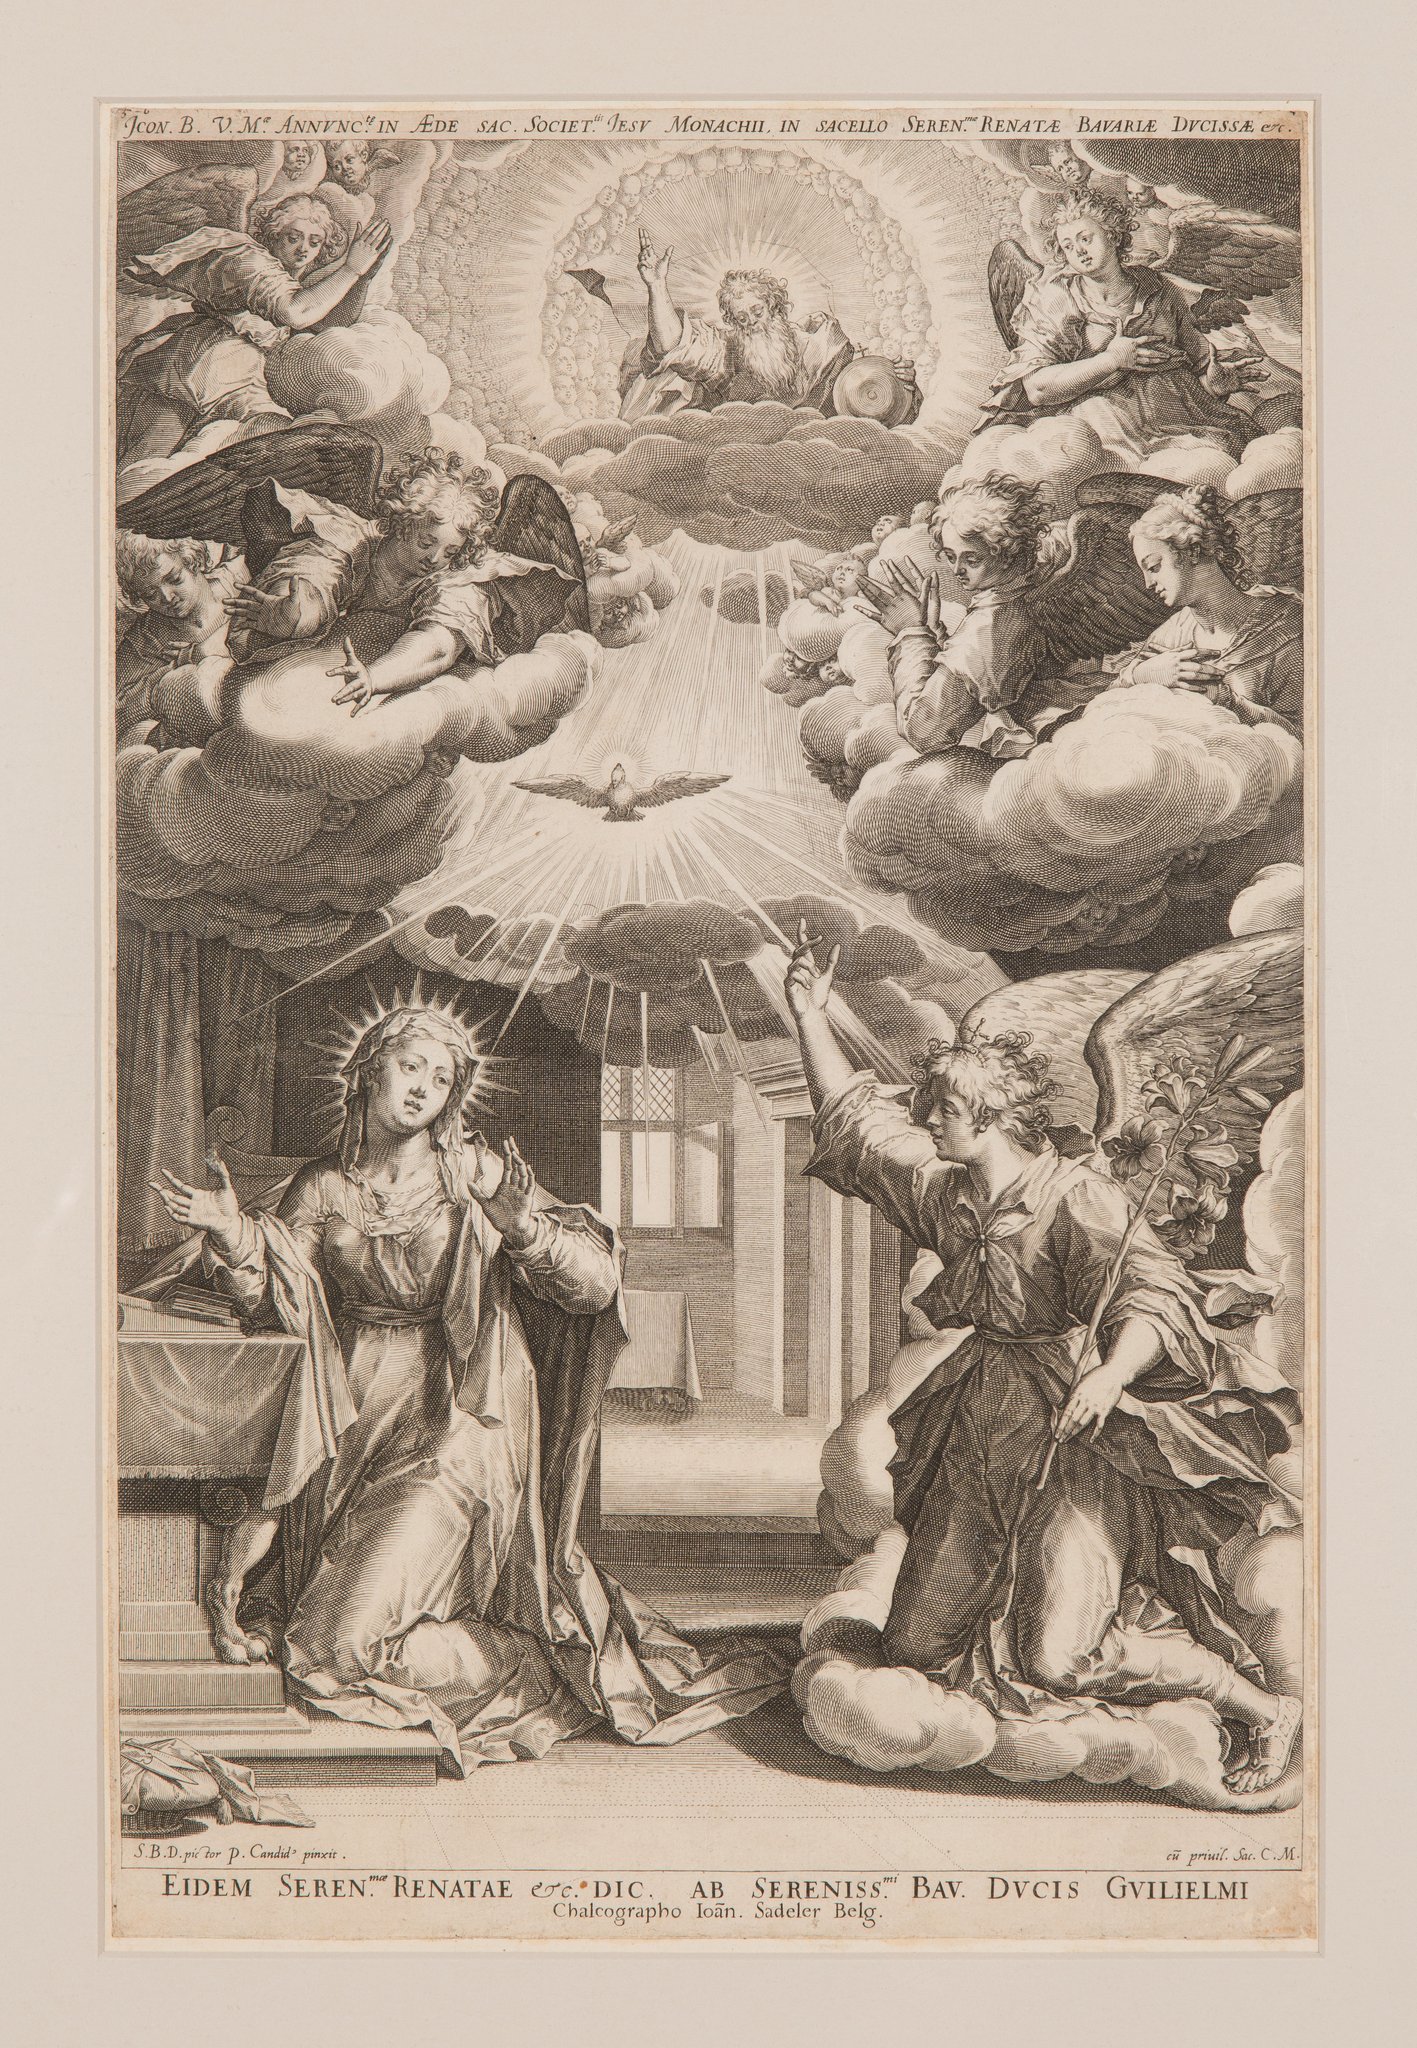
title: The Annunciation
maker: johann sadeler (i)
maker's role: artist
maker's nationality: netherlandish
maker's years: 1550-1601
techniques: engraving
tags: angels,virgin mary,archangel gabriel,annunciation